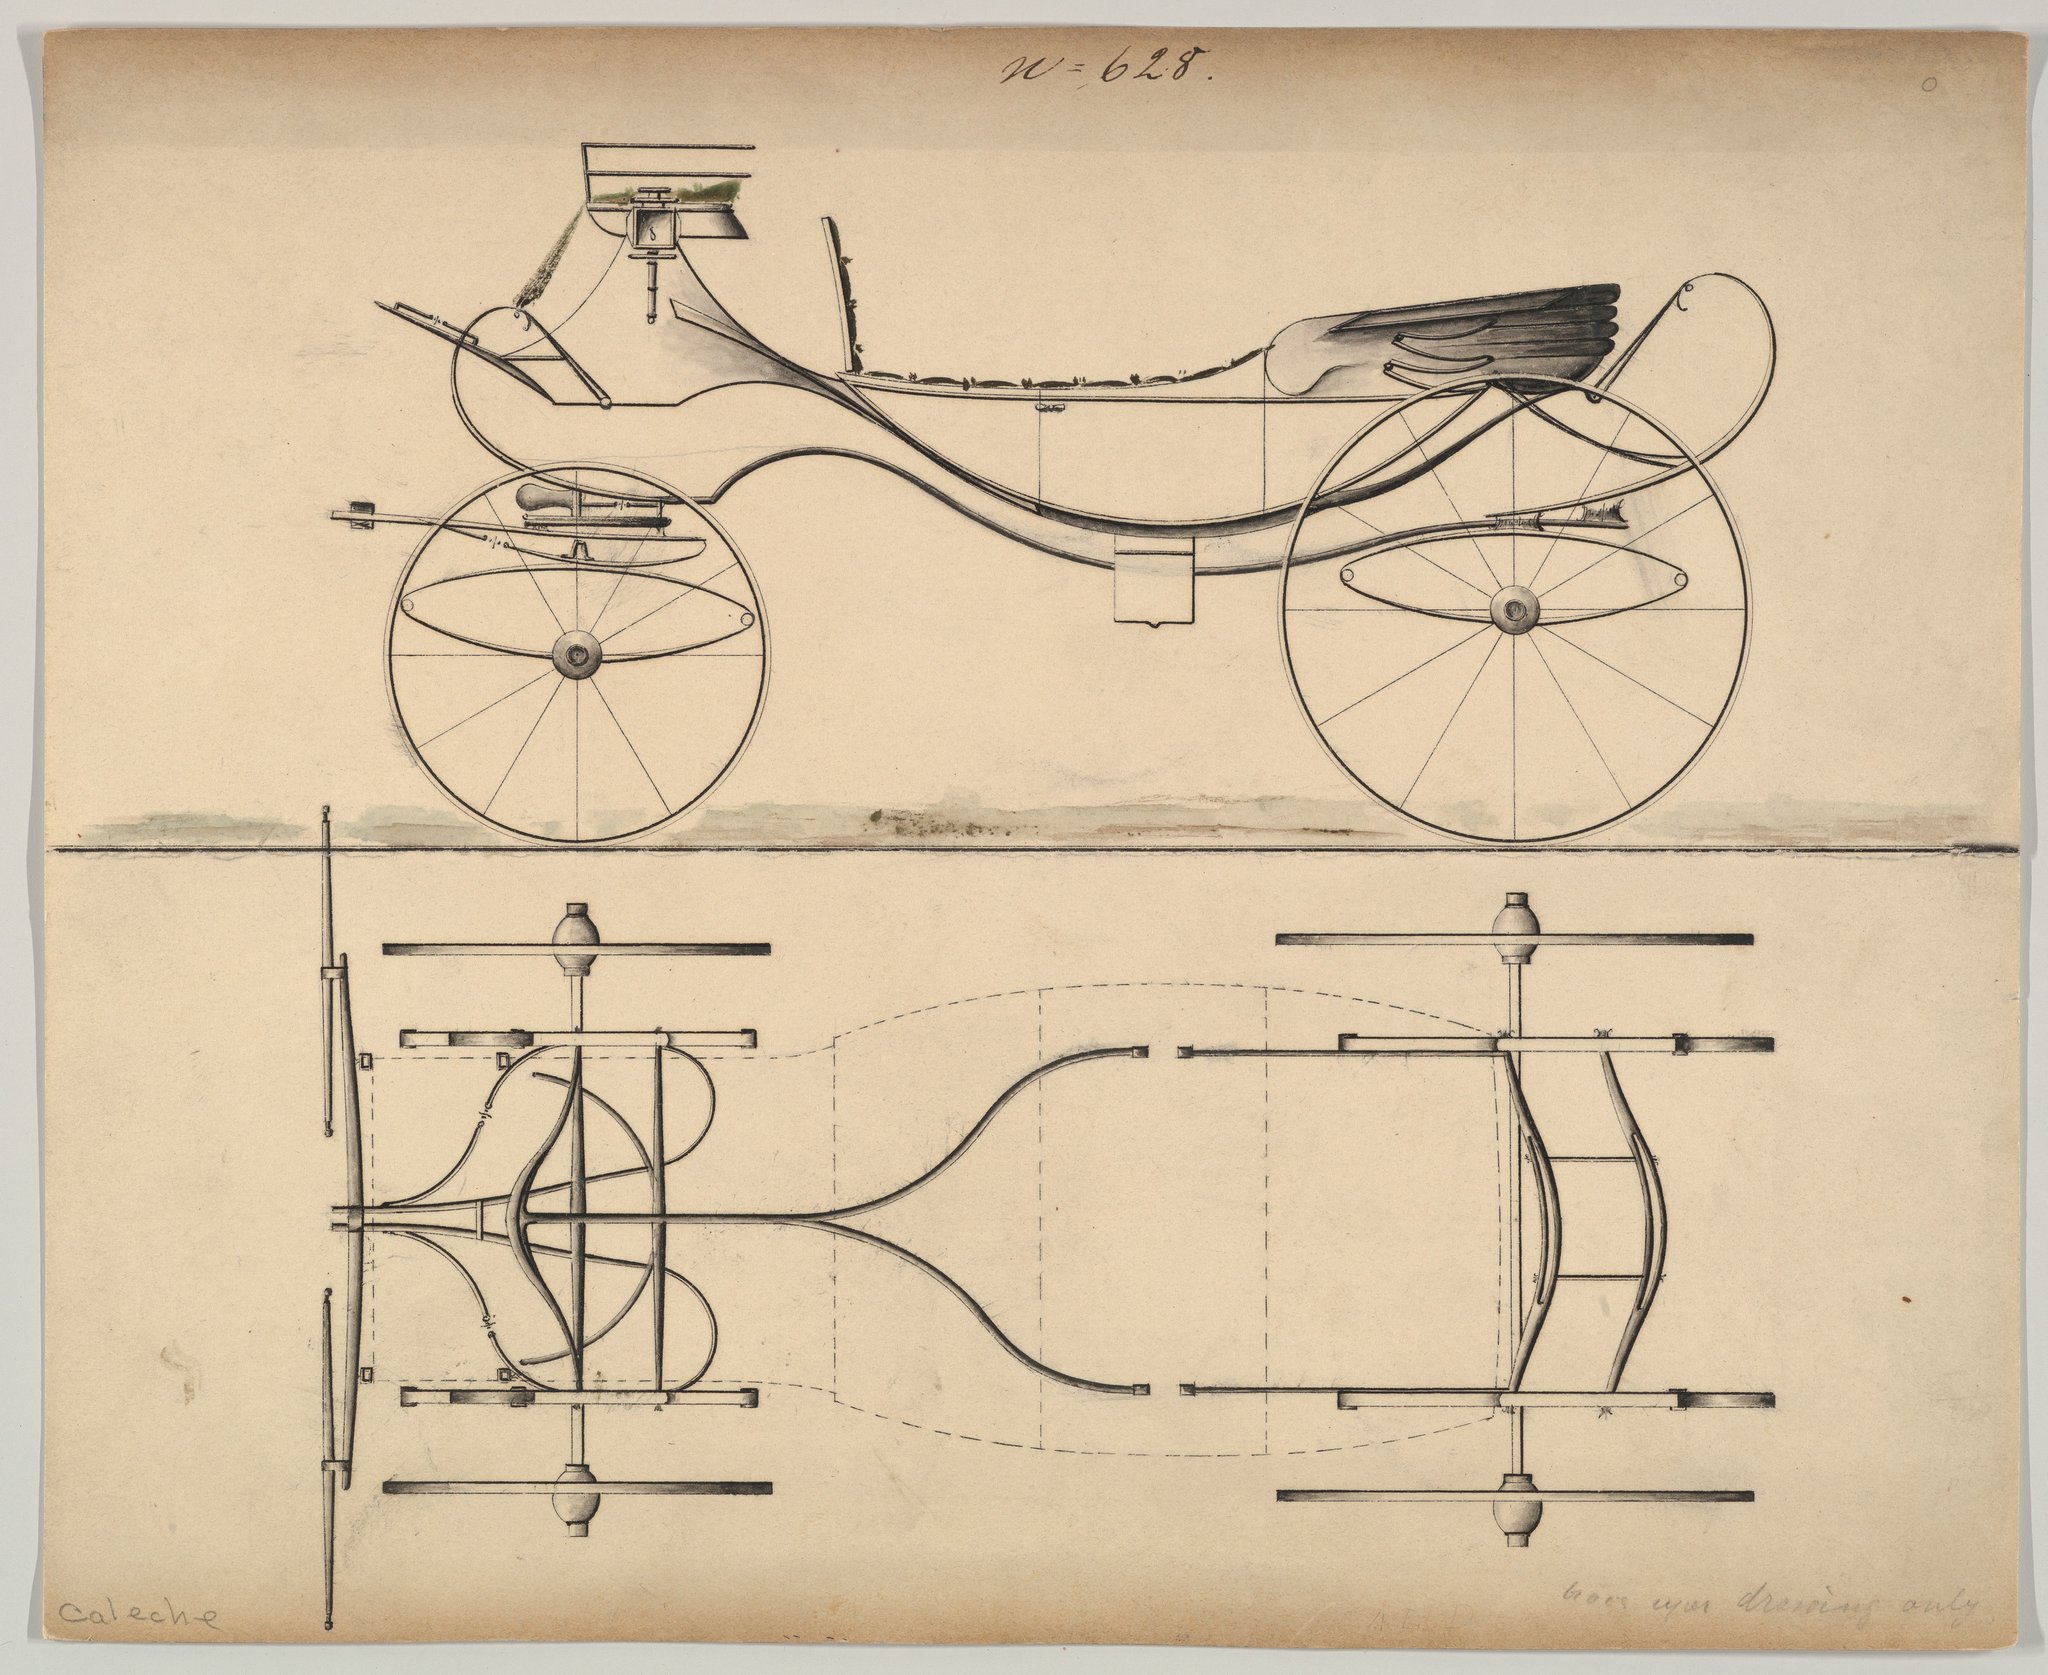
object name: drawing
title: Caleche # 628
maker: brewster & co.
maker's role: manufacturer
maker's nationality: american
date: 1850-1870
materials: gouache, ink, watercolor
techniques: pen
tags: carriages